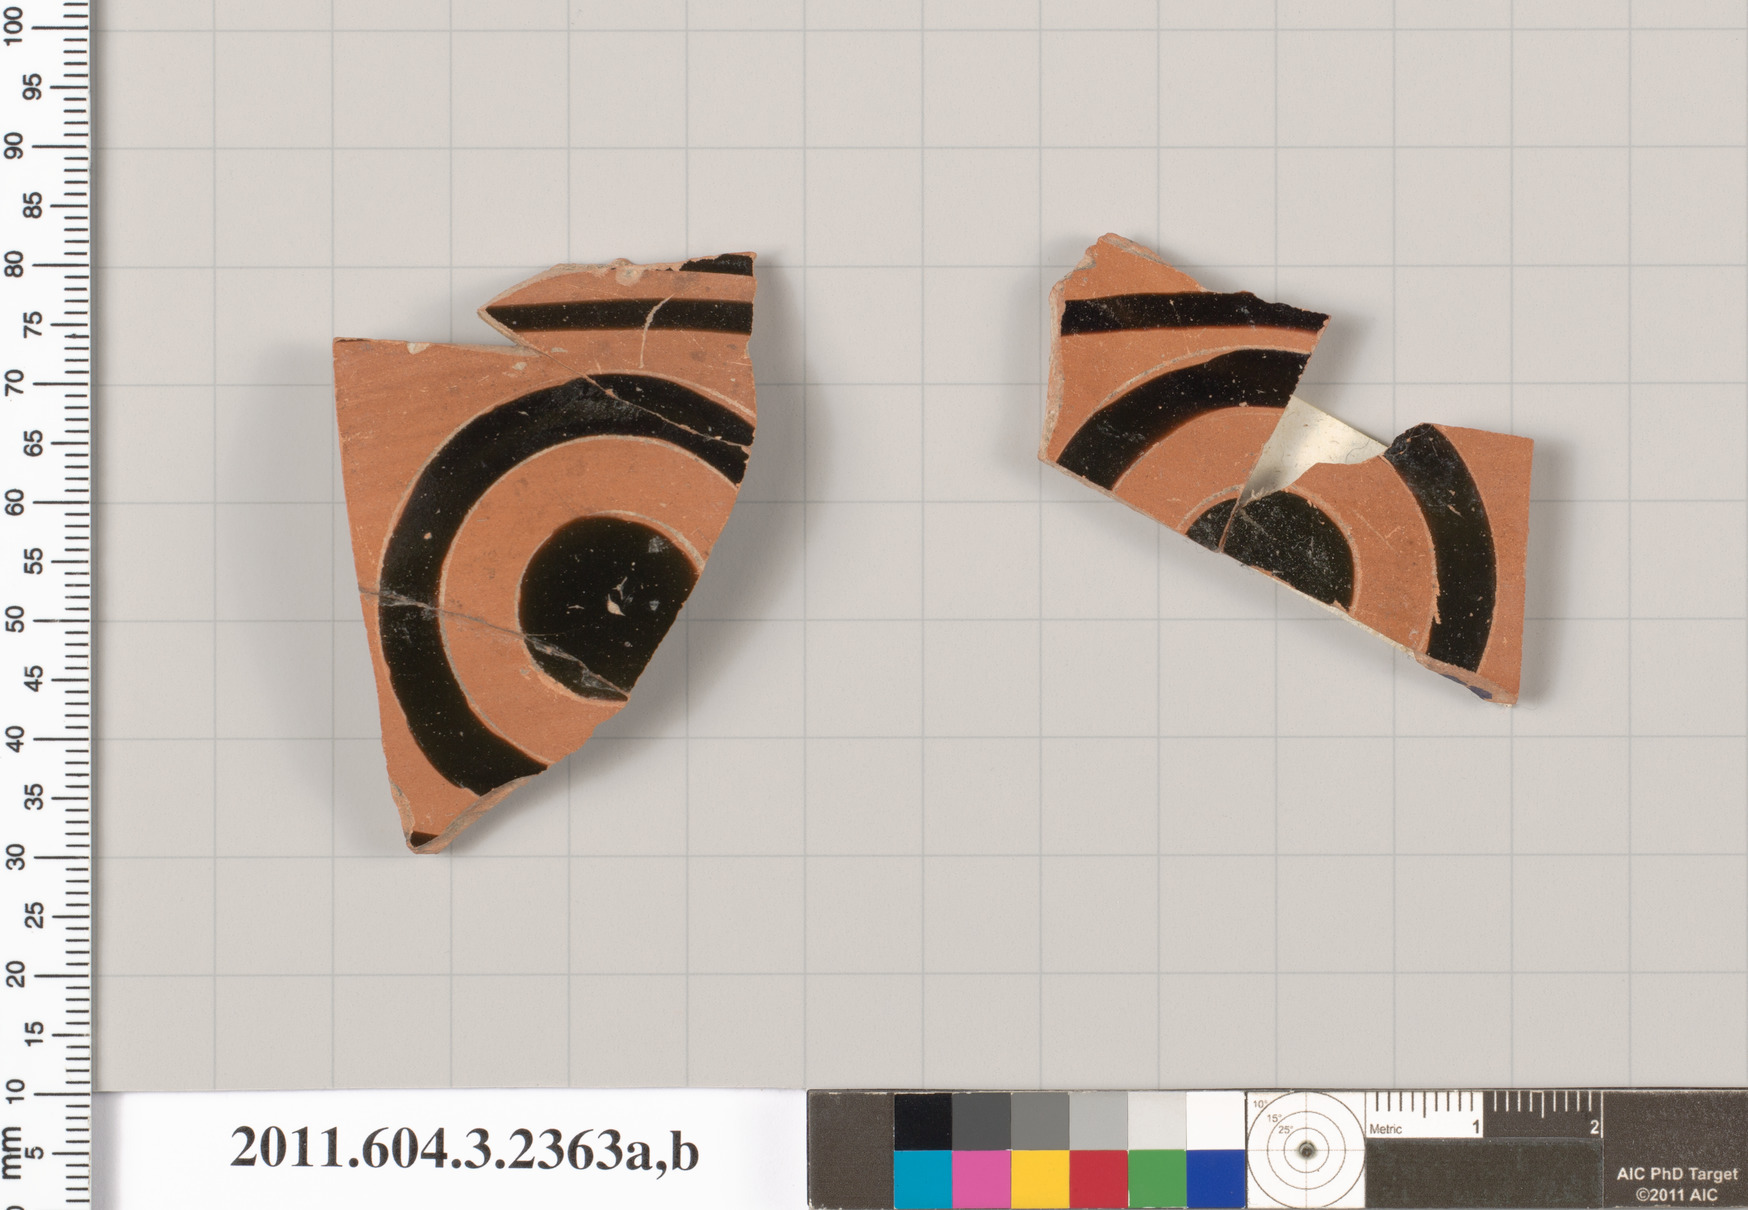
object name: kylix fragment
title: Terracotta fragments of a kylix: eye-cup (drinking cup)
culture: greek, attic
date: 530-500 BCE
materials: terracotta